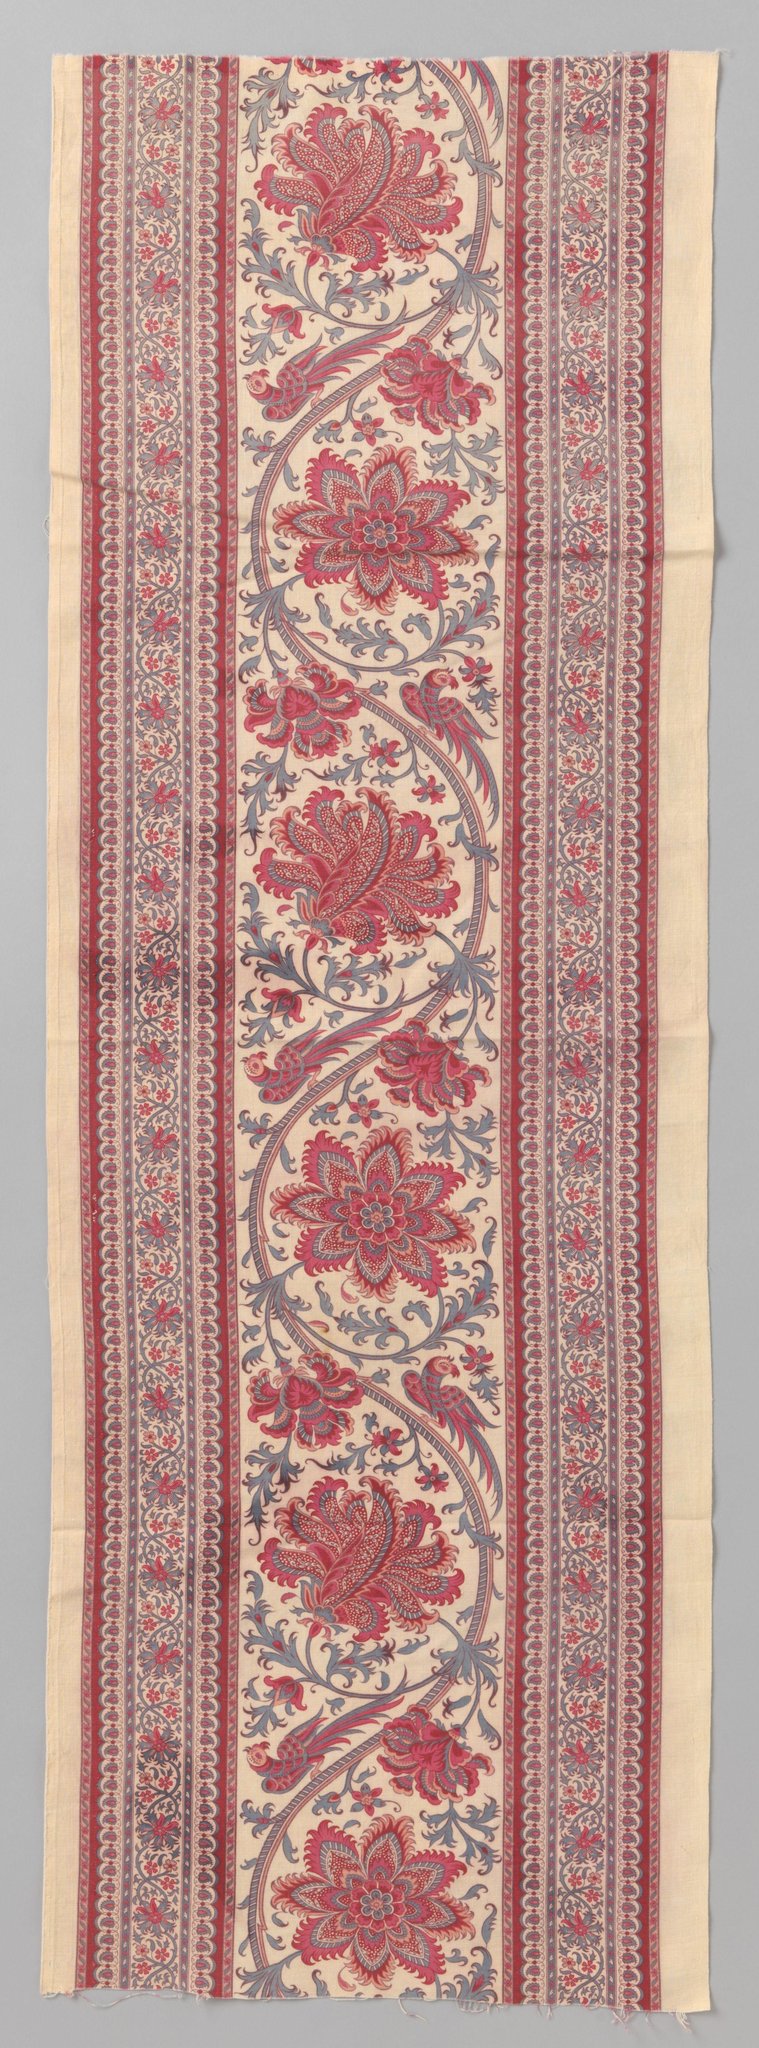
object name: interieuronderdeel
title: Gordijnval van imitatiesits, op stevig wit katoen gedrukt met breed randpatroon van golvende twijgen met palmet- rozetbloemen en vogels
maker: Anonymous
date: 1900-1925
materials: cotton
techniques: printing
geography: france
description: Gordijnval (A,B,C) van imitatiesits, op stevig wit katoen gedrukt met breed randpatroon van golvende twijgen met palmet- en rozetbloemen en vogels in rood, cerise, roze en grijsblauw met paarse trek, gevat in smallere rode lijsten met een vergelijkbaar patroon, namelijk met dubbele geslingerde twijgen, rozetbloemen en bloesems op een wit lint gedrukt. In elke schulp een blad. Scheidingslijsten in lichtblauw en roze met slingerende rank. Frankrijk of Elzas? Ca. 1900-1925.